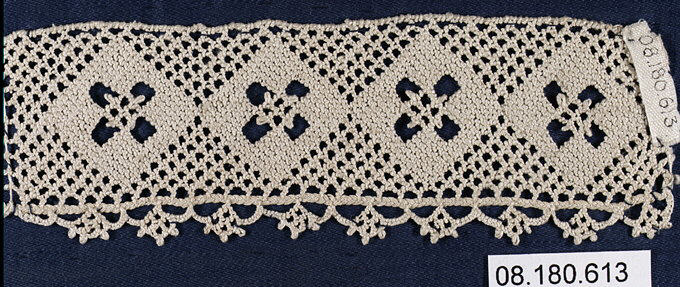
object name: fragment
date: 1801-1900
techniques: lace